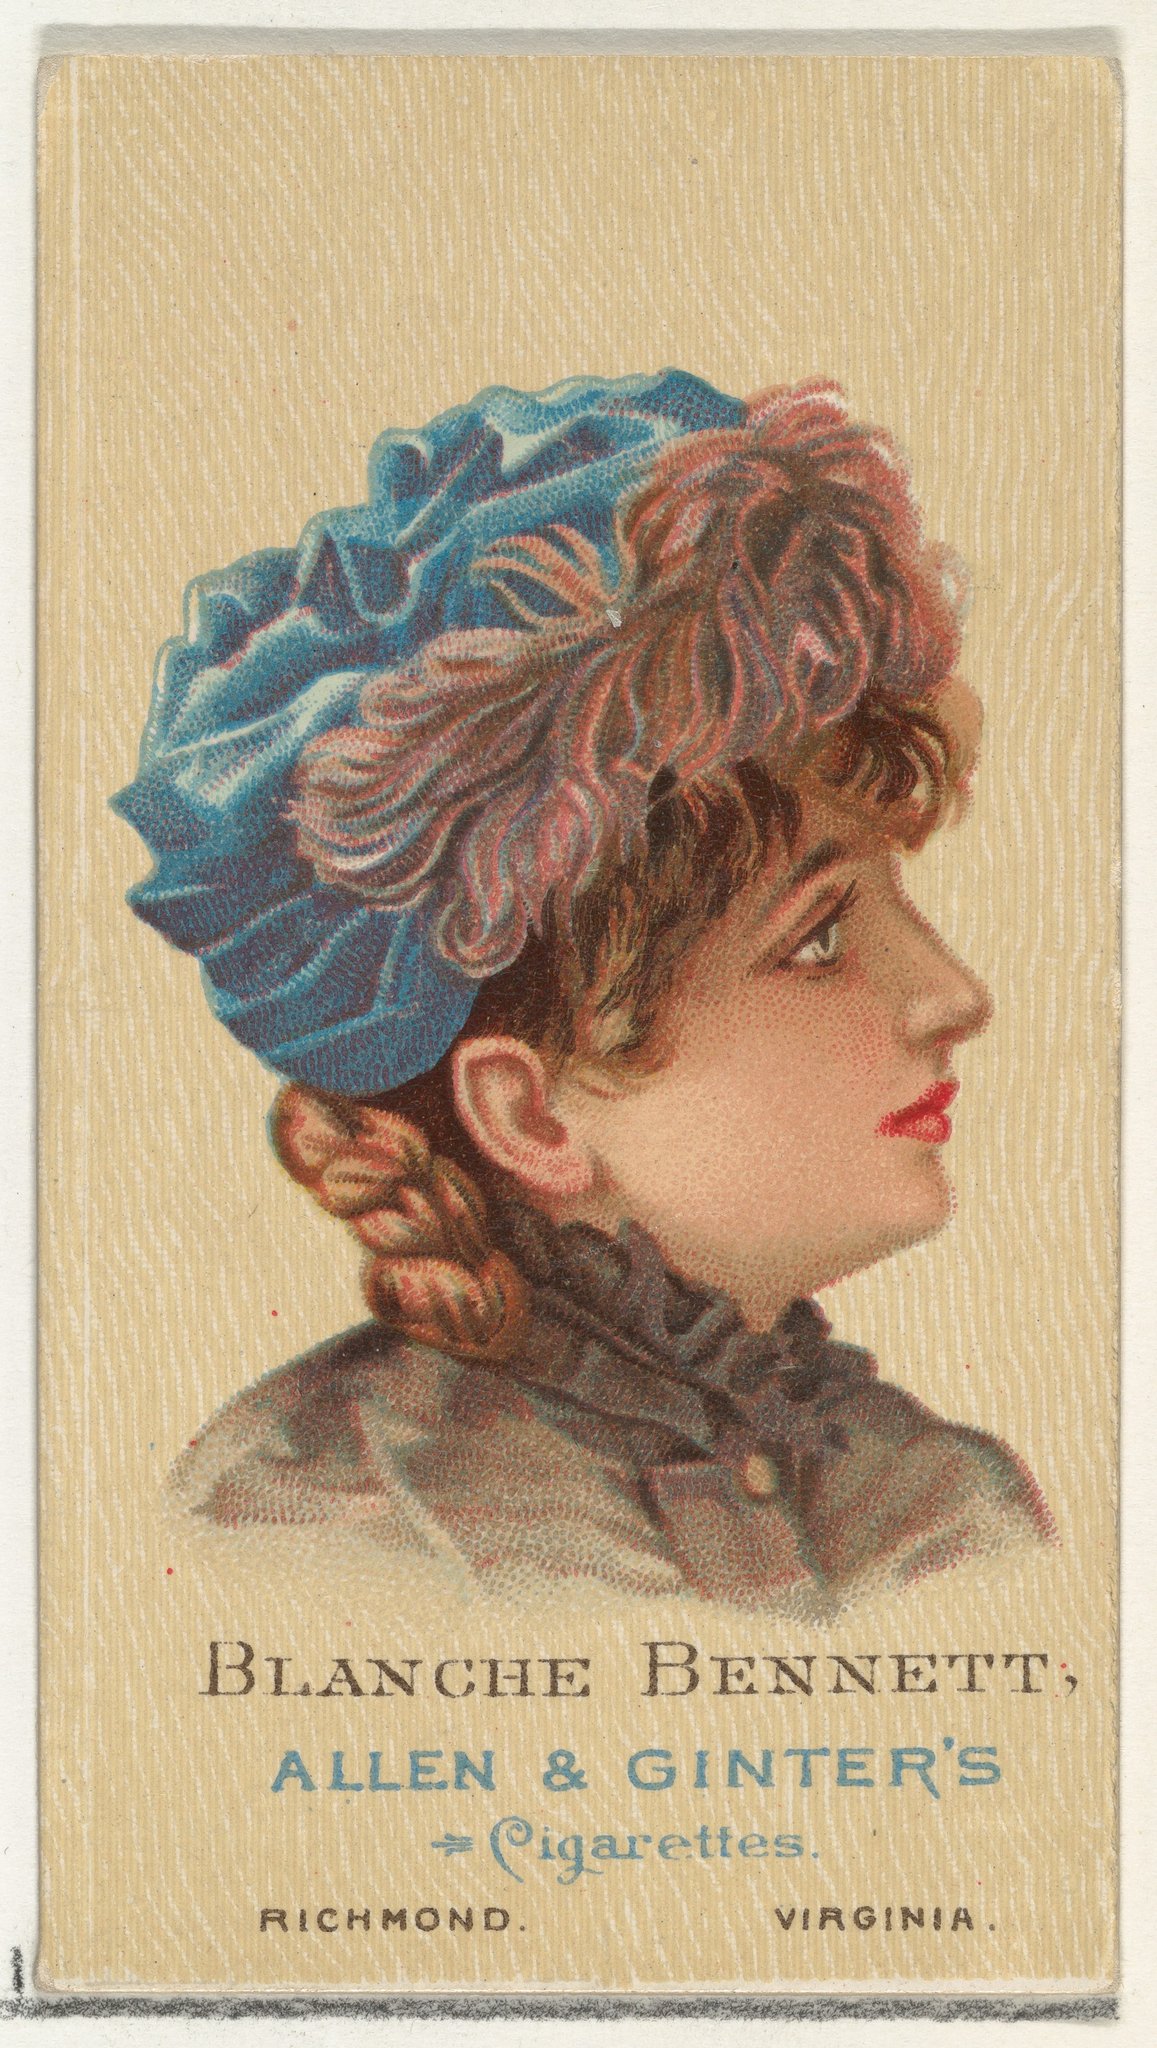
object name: print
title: Blanche Bennett, from World's Beauties, Series 2 (N27) for Allen & Ginter Cigarettes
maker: allen & ginter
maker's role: publisher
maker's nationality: american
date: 1888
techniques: color lithograph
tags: women